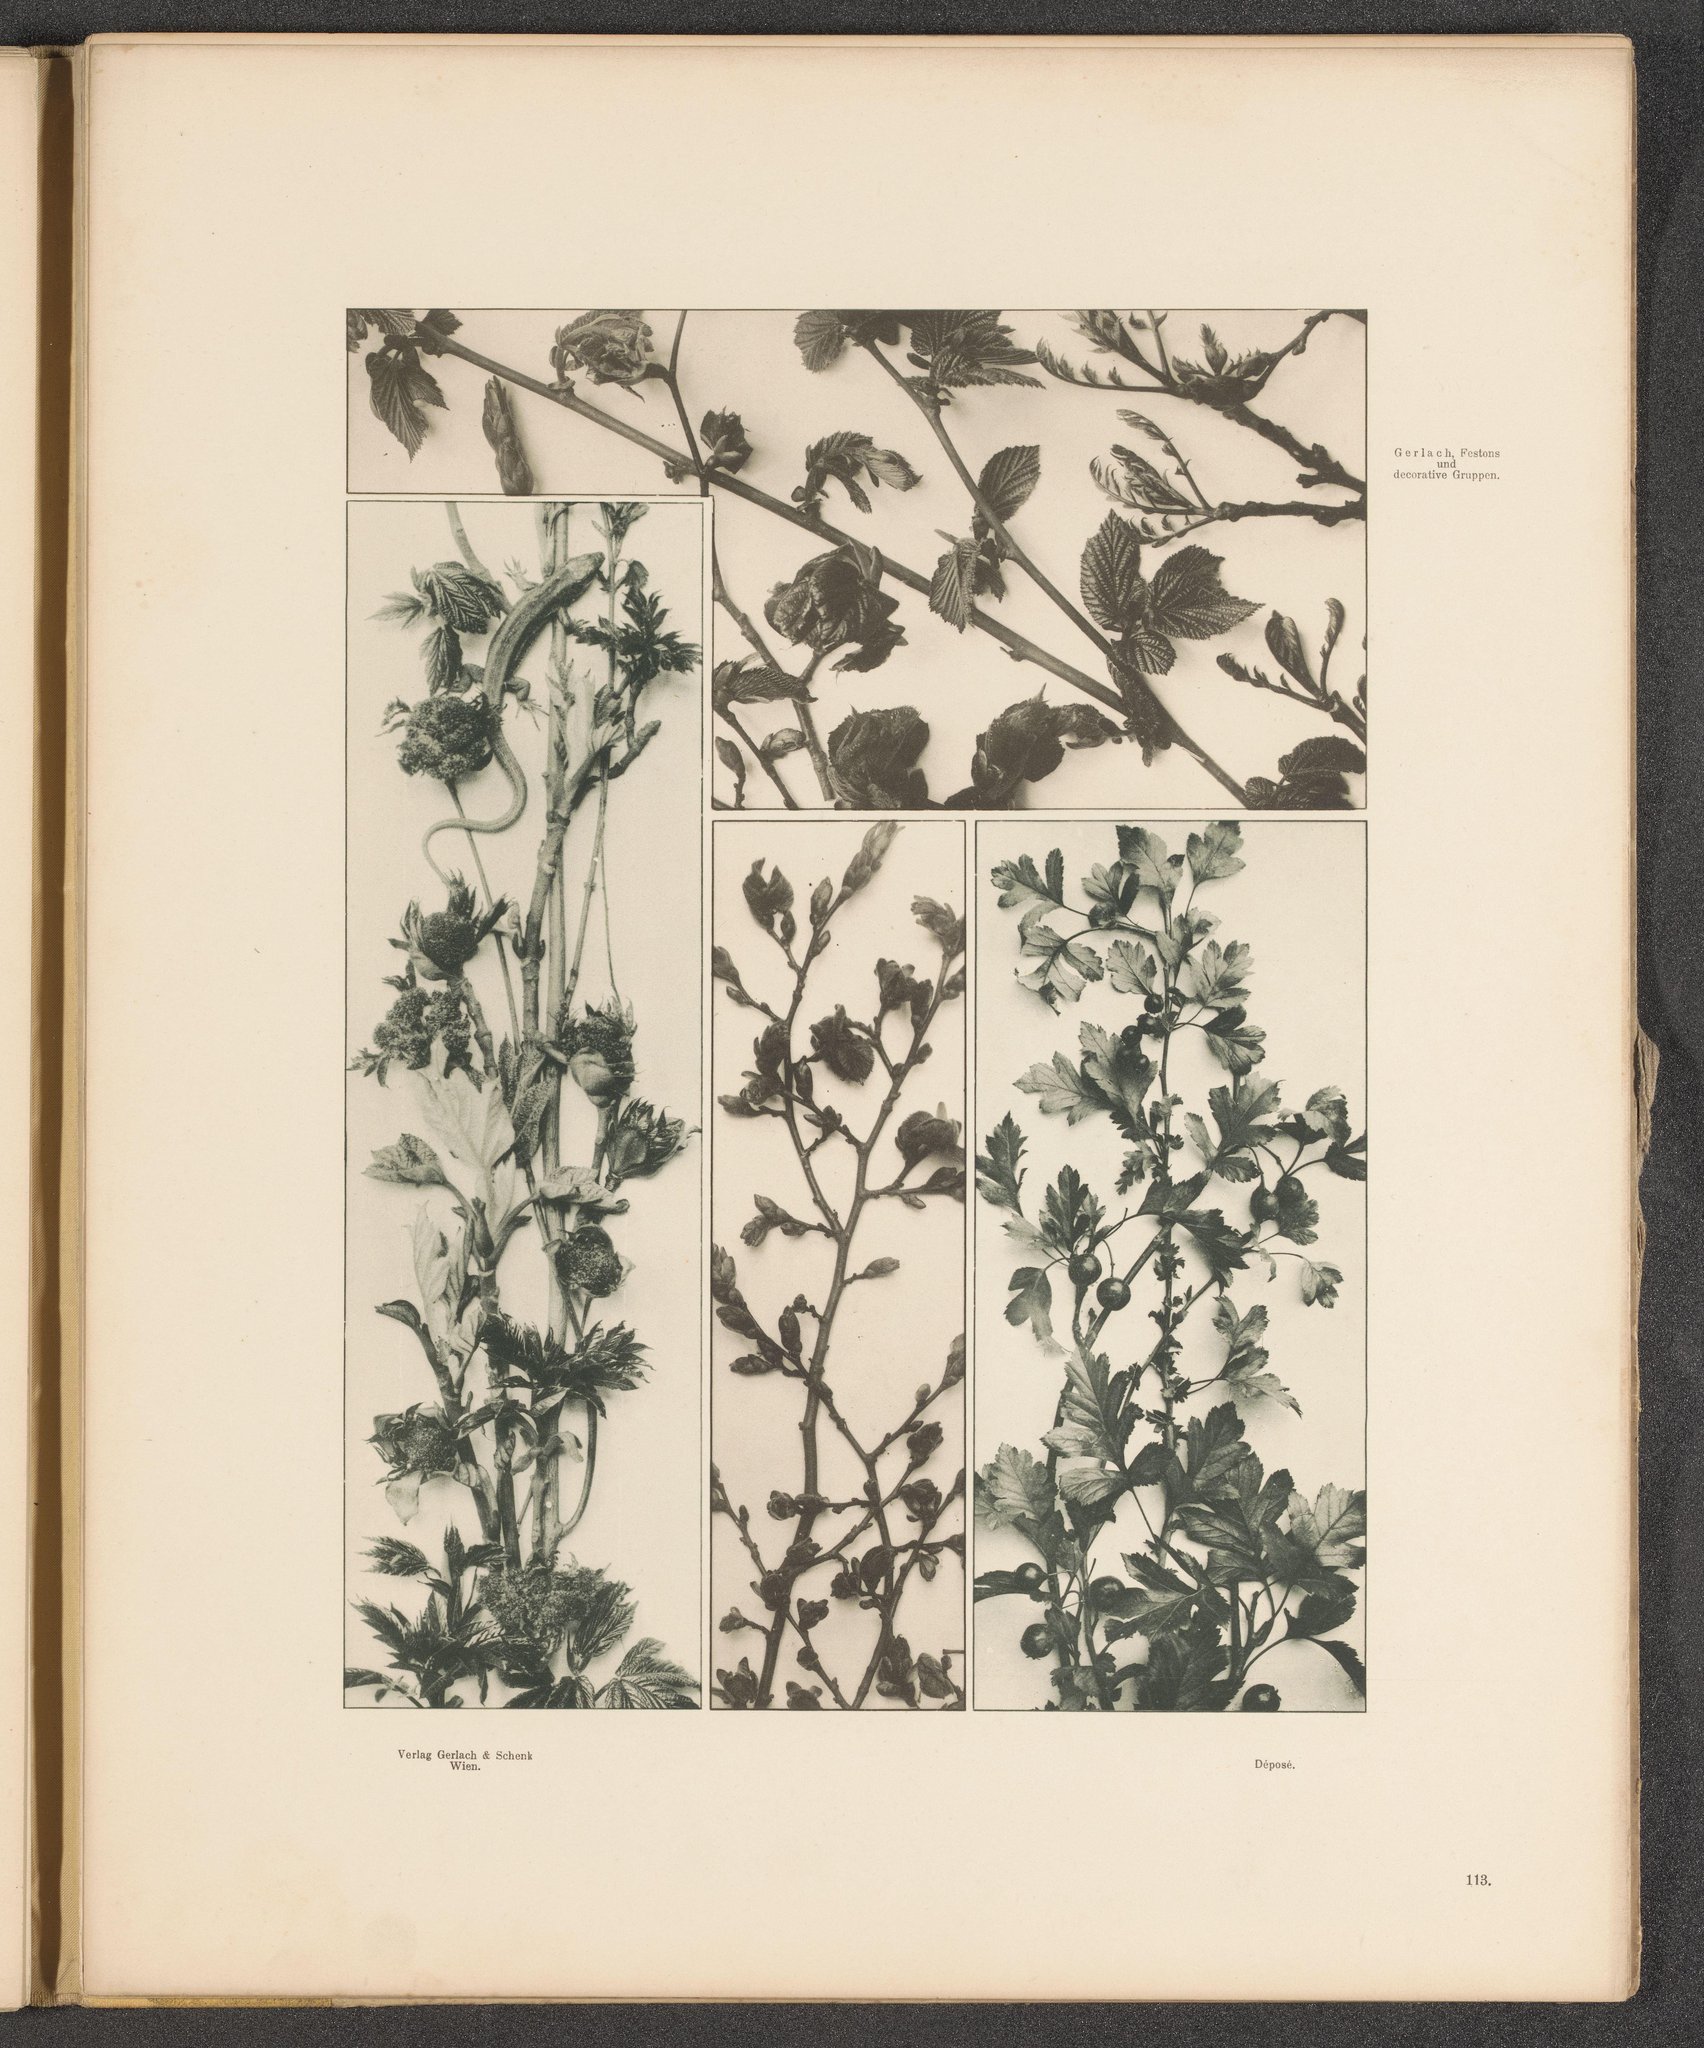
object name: page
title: Vier vlakken met esdoorntakken, meidoorntakken, hazelaartakken en een hagedis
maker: Anonymous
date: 1887-1897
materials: paper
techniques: photograph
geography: vienna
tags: lizards, trees: acer (branch, stick), shrubs: hazel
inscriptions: number: ‘113.’